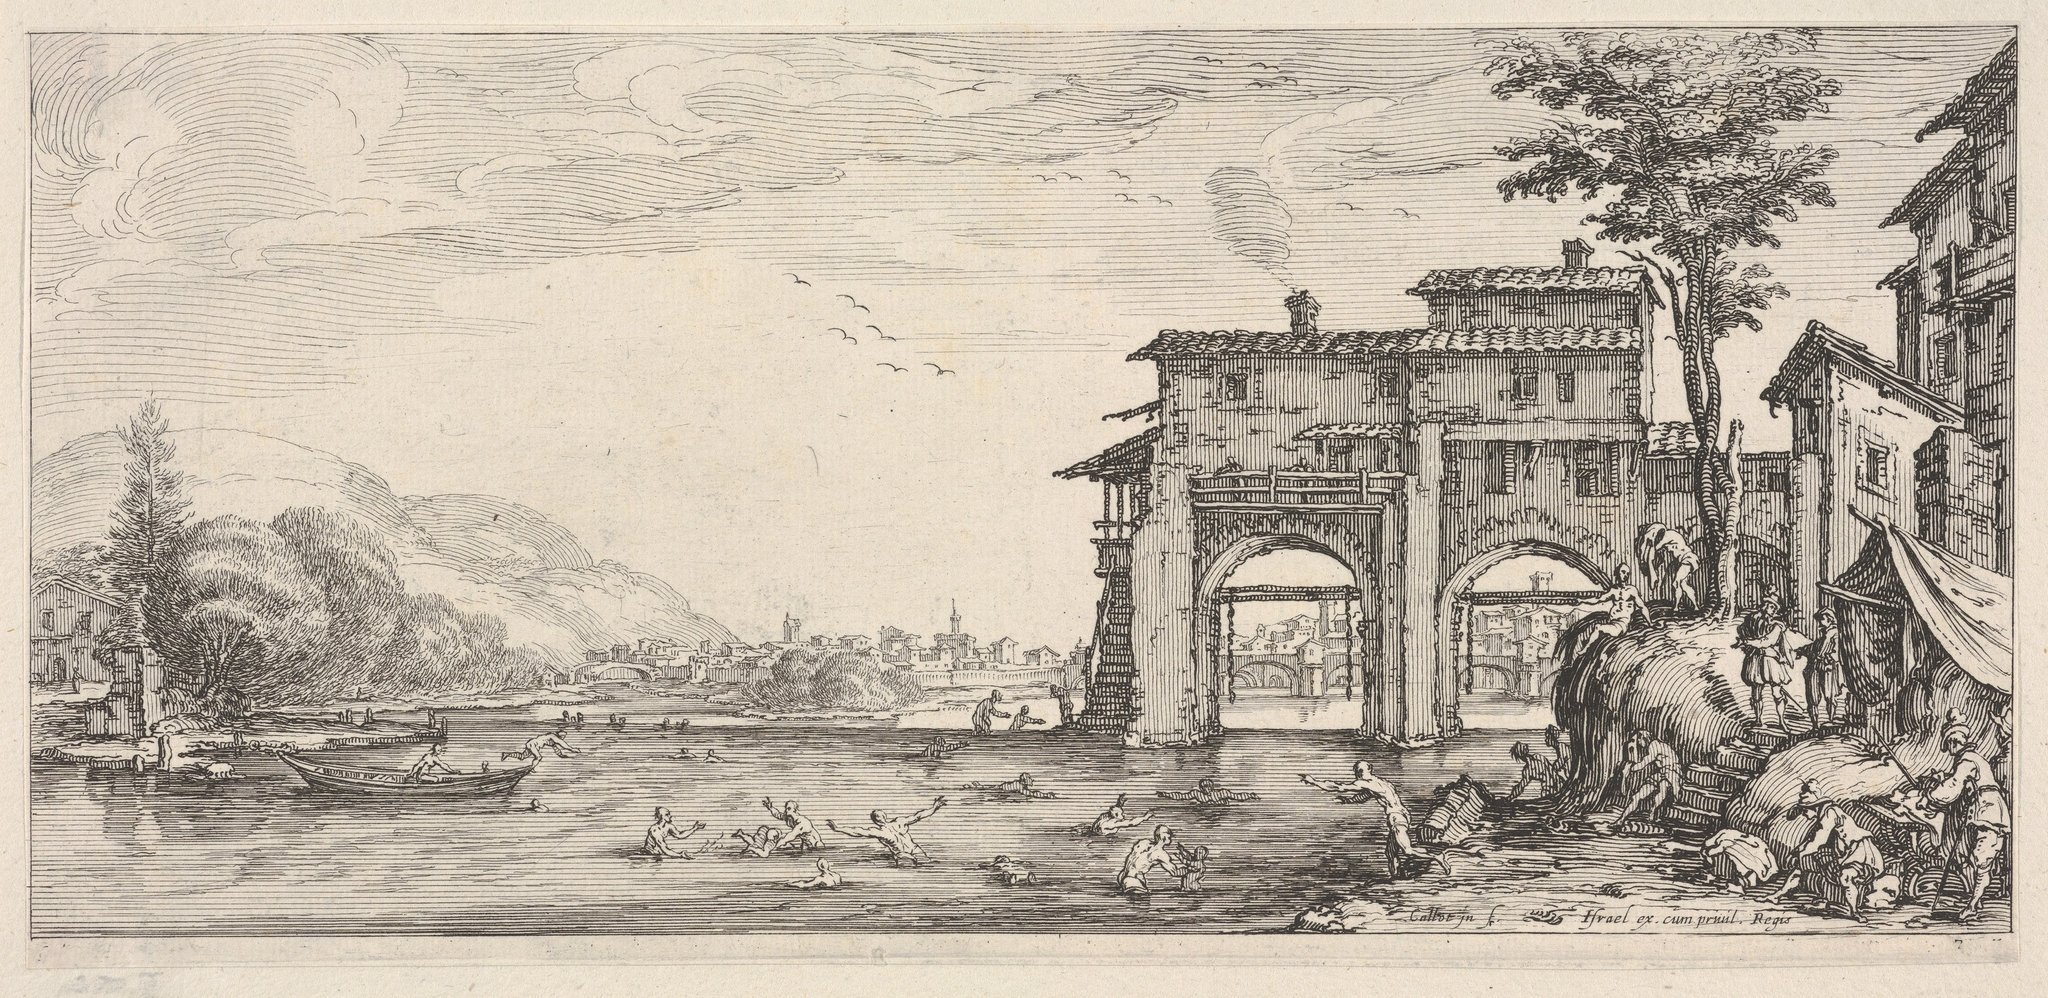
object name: print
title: View of bathers and a large building at the right, from "Italian landscapes" (Diverse vedute designate in Fiorenza / Paysages italiens)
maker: jacques callot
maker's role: artist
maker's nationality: french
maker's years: 1592-1635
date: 1618-1635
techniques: etching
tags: human figures,buildings,landscapes,bathing